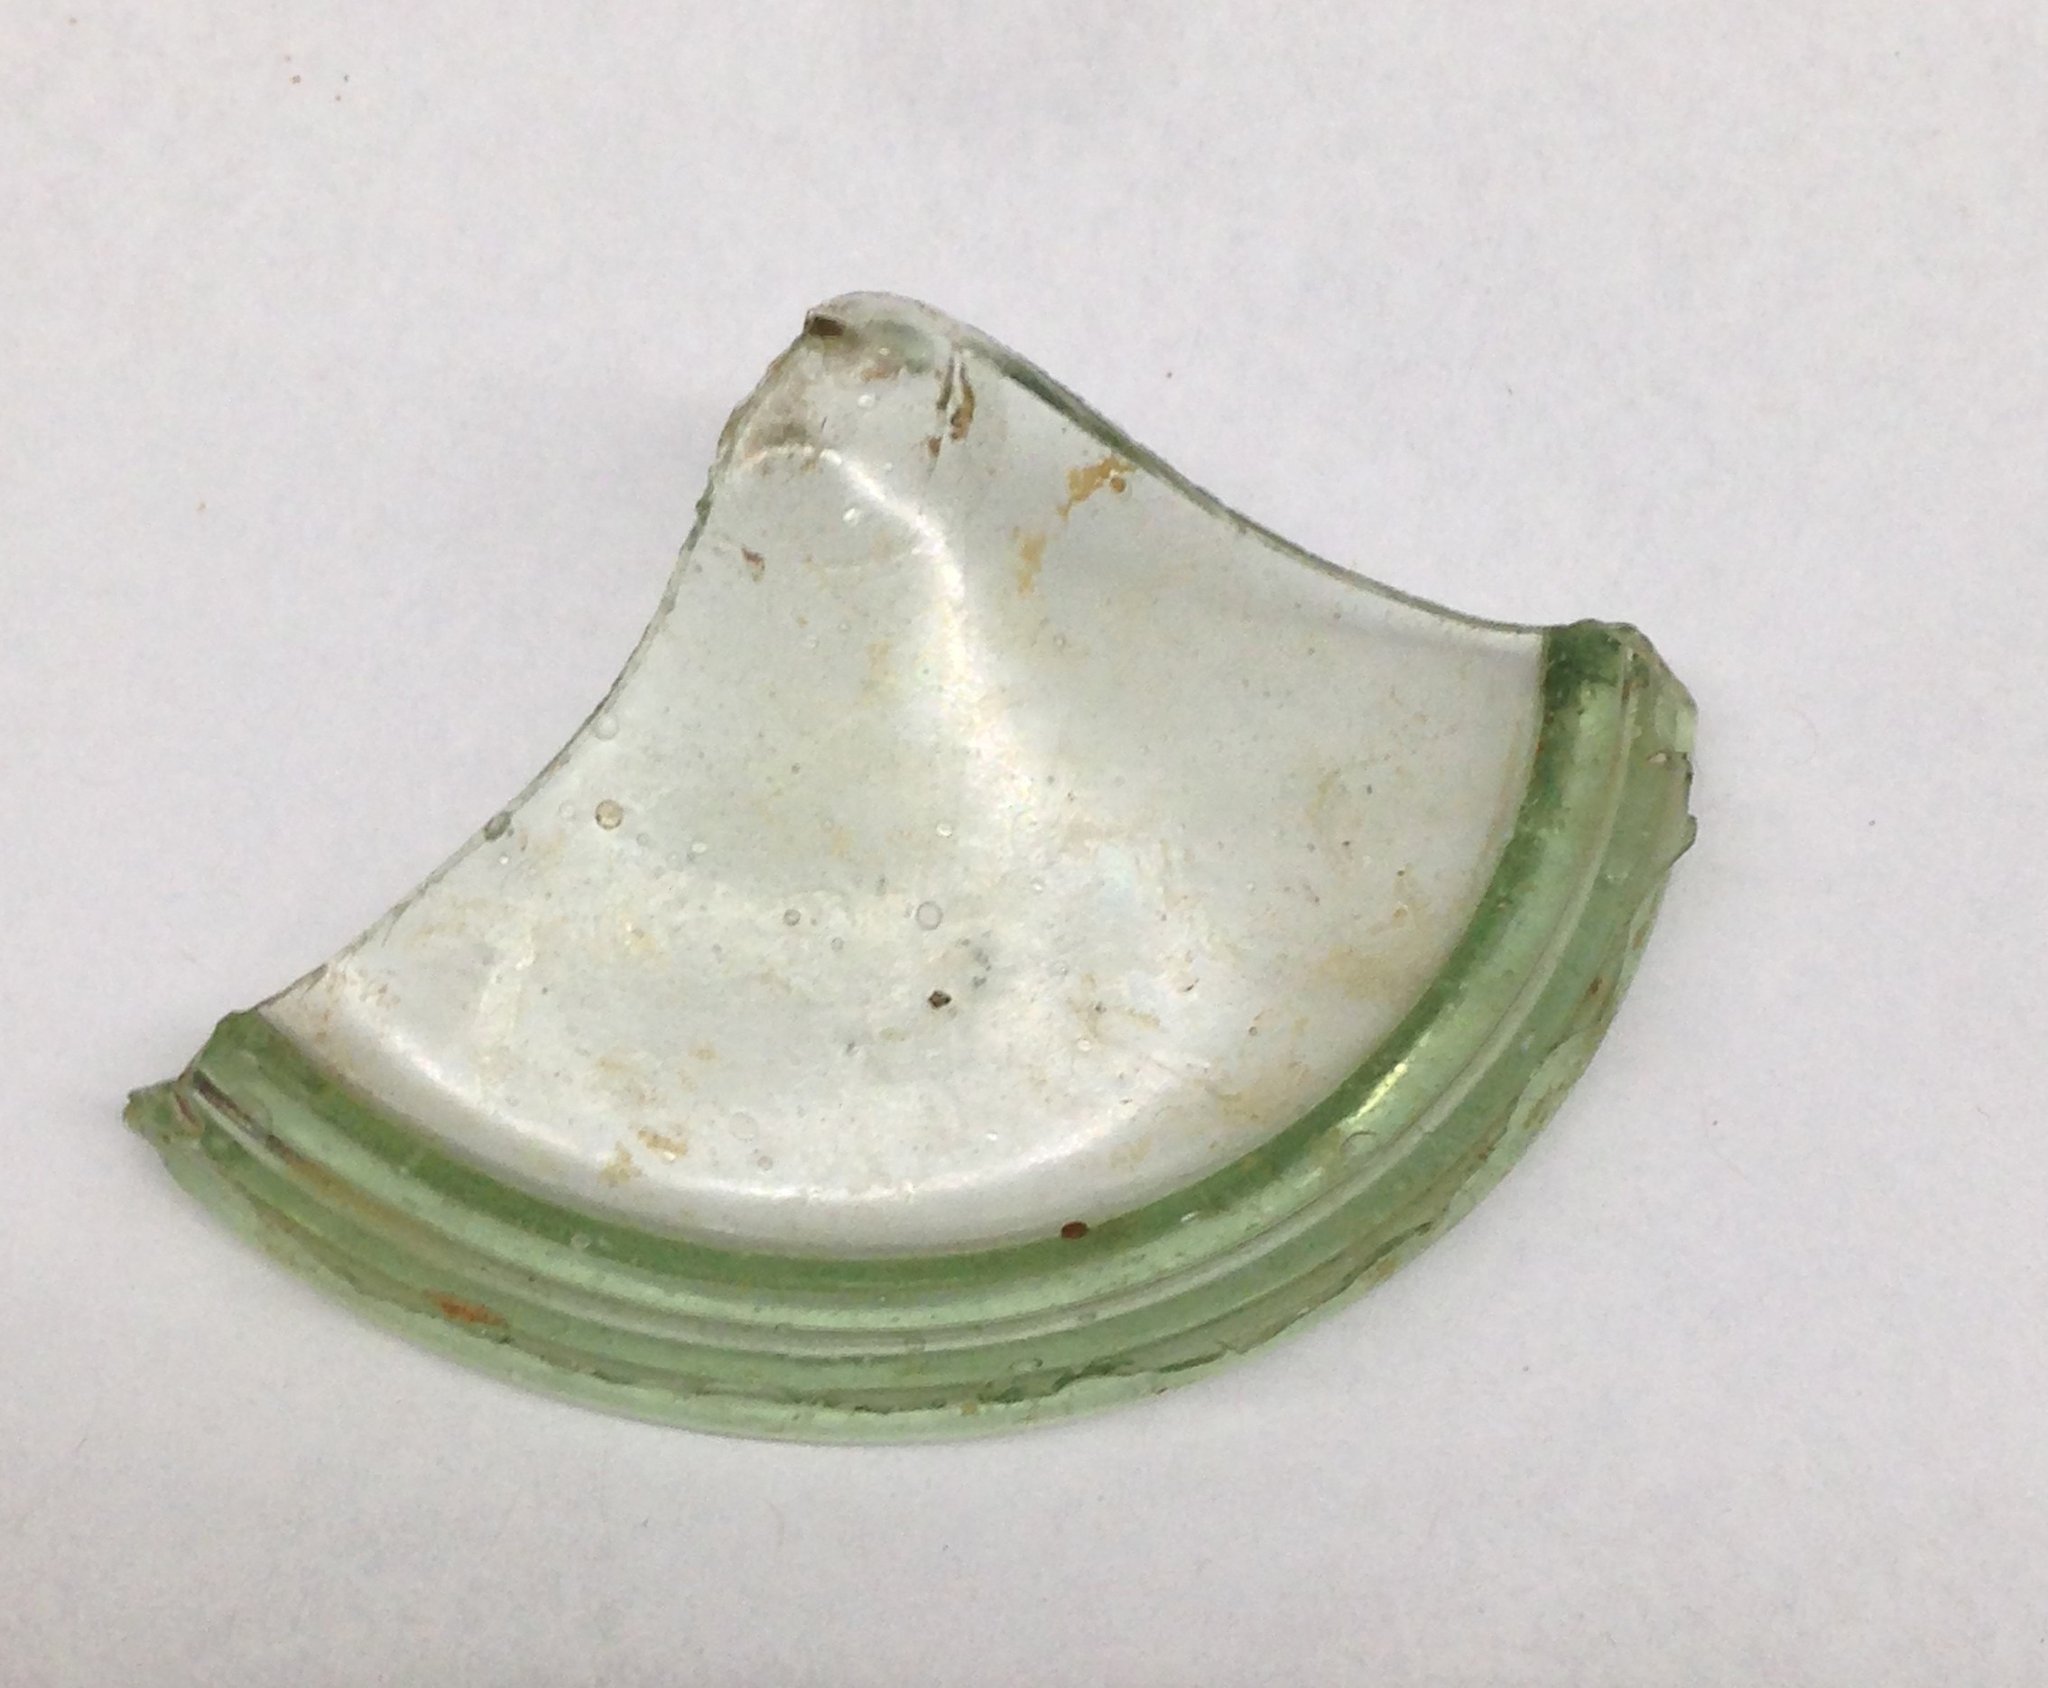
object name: fragment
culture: european or middle eastern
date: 1150-1250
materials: ceramic, glass